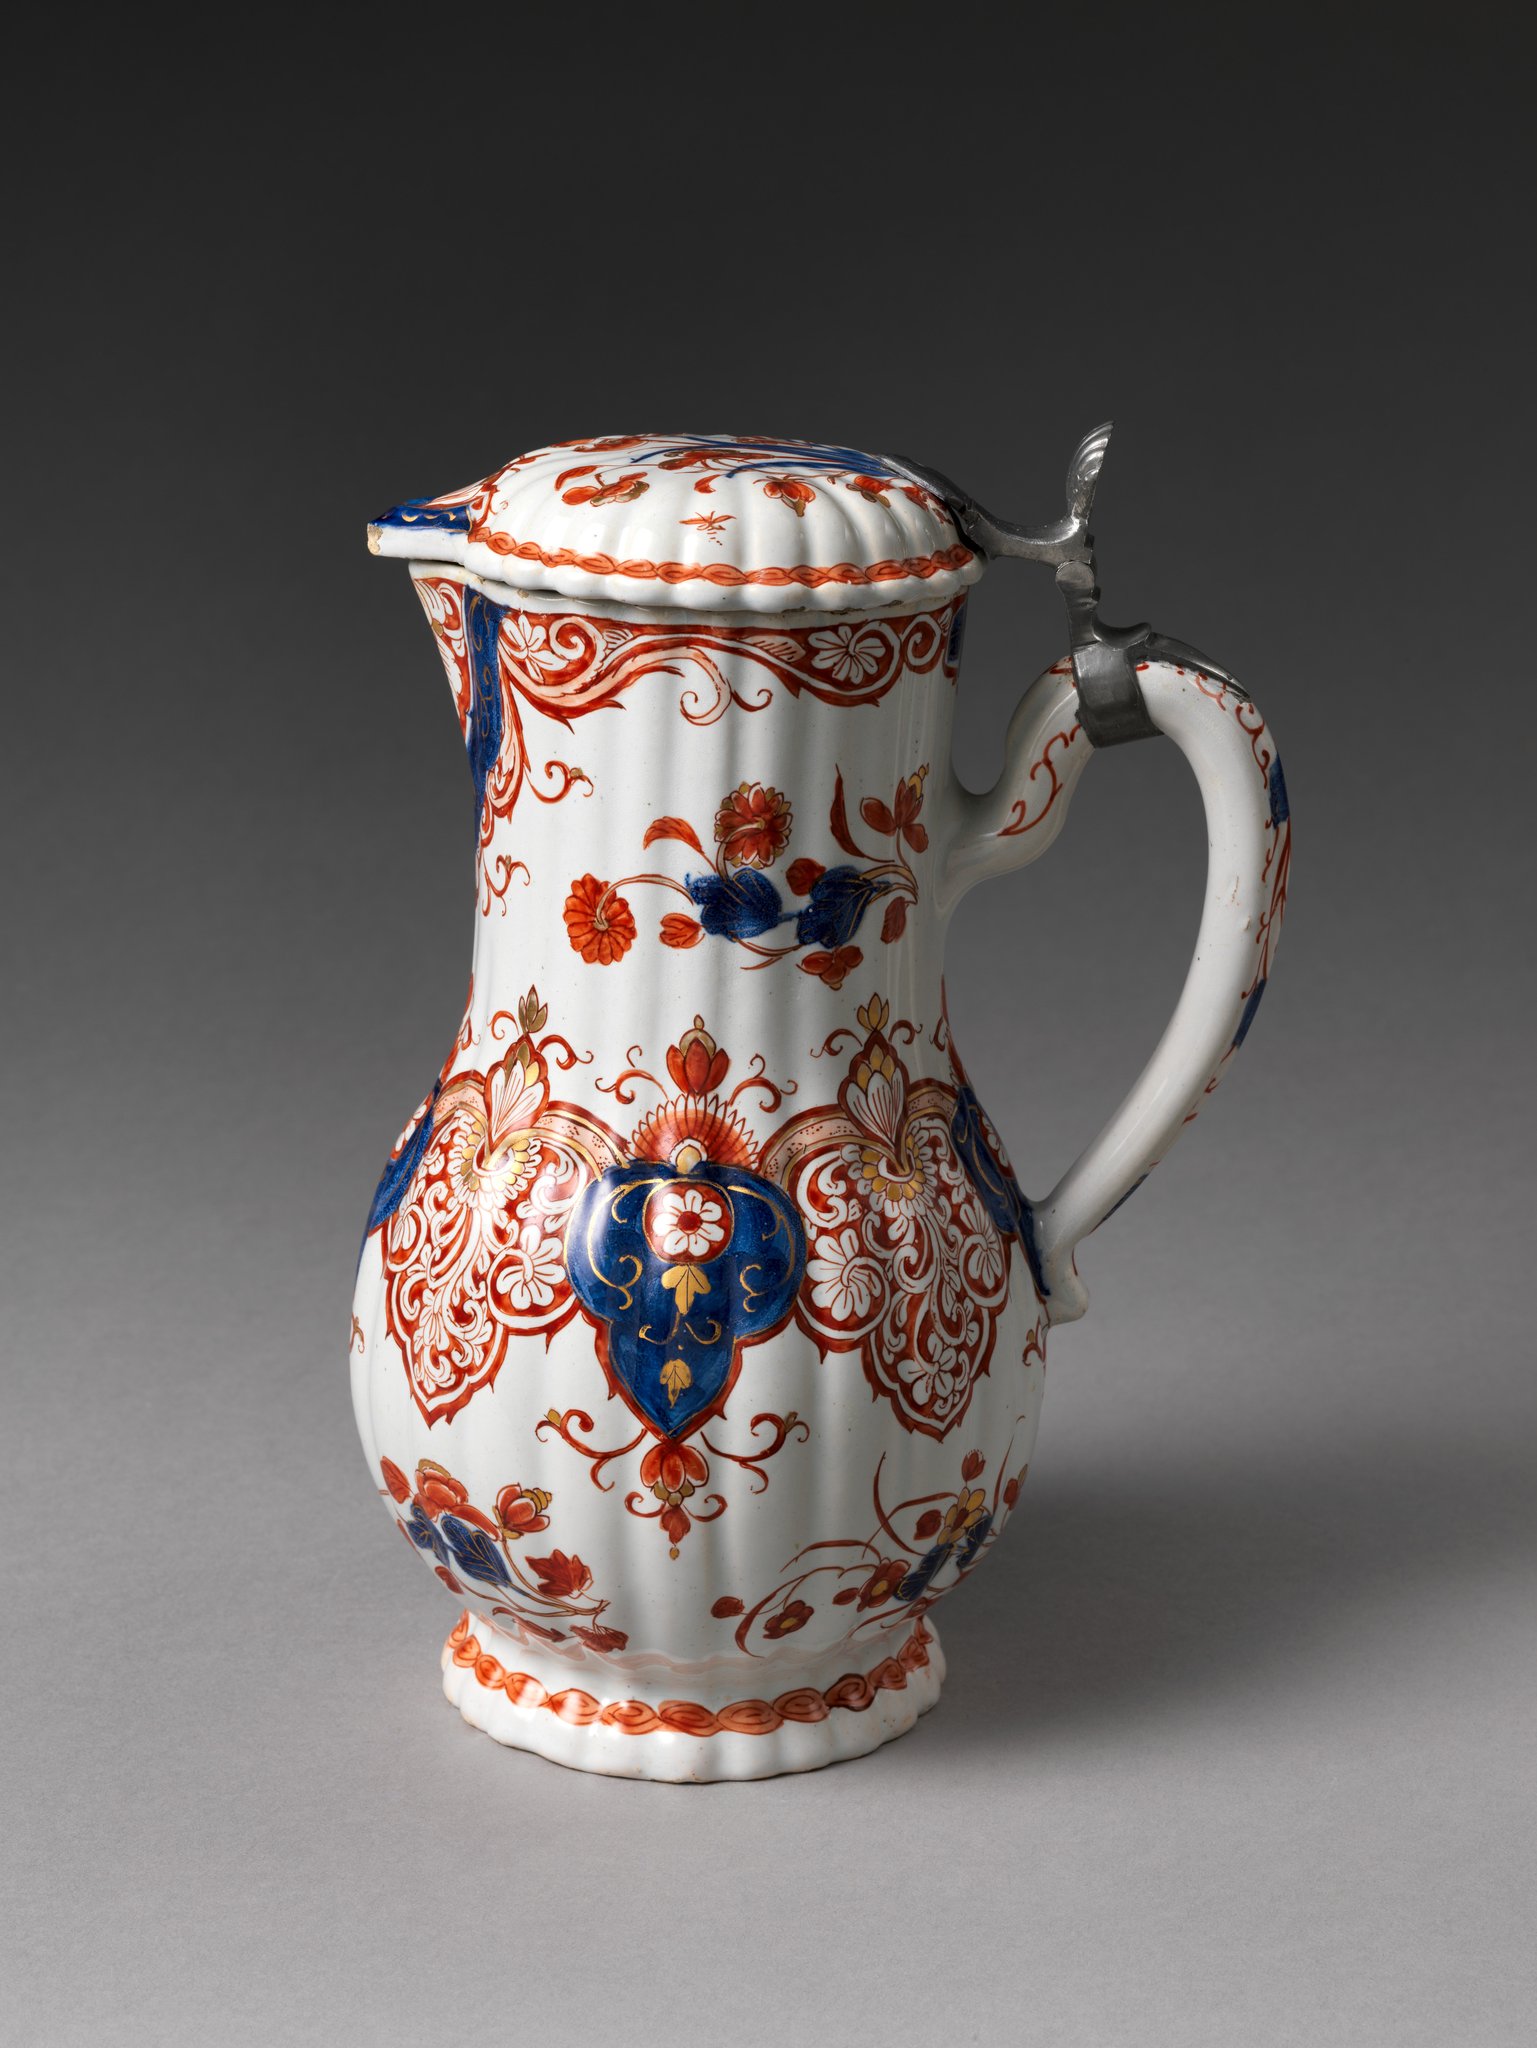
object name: jug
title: Jug with stylized floral pendants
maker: the "greek a" factory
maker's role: maker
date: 1701-1715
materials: earthenware, enamel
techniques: painting, glazing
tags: flowers